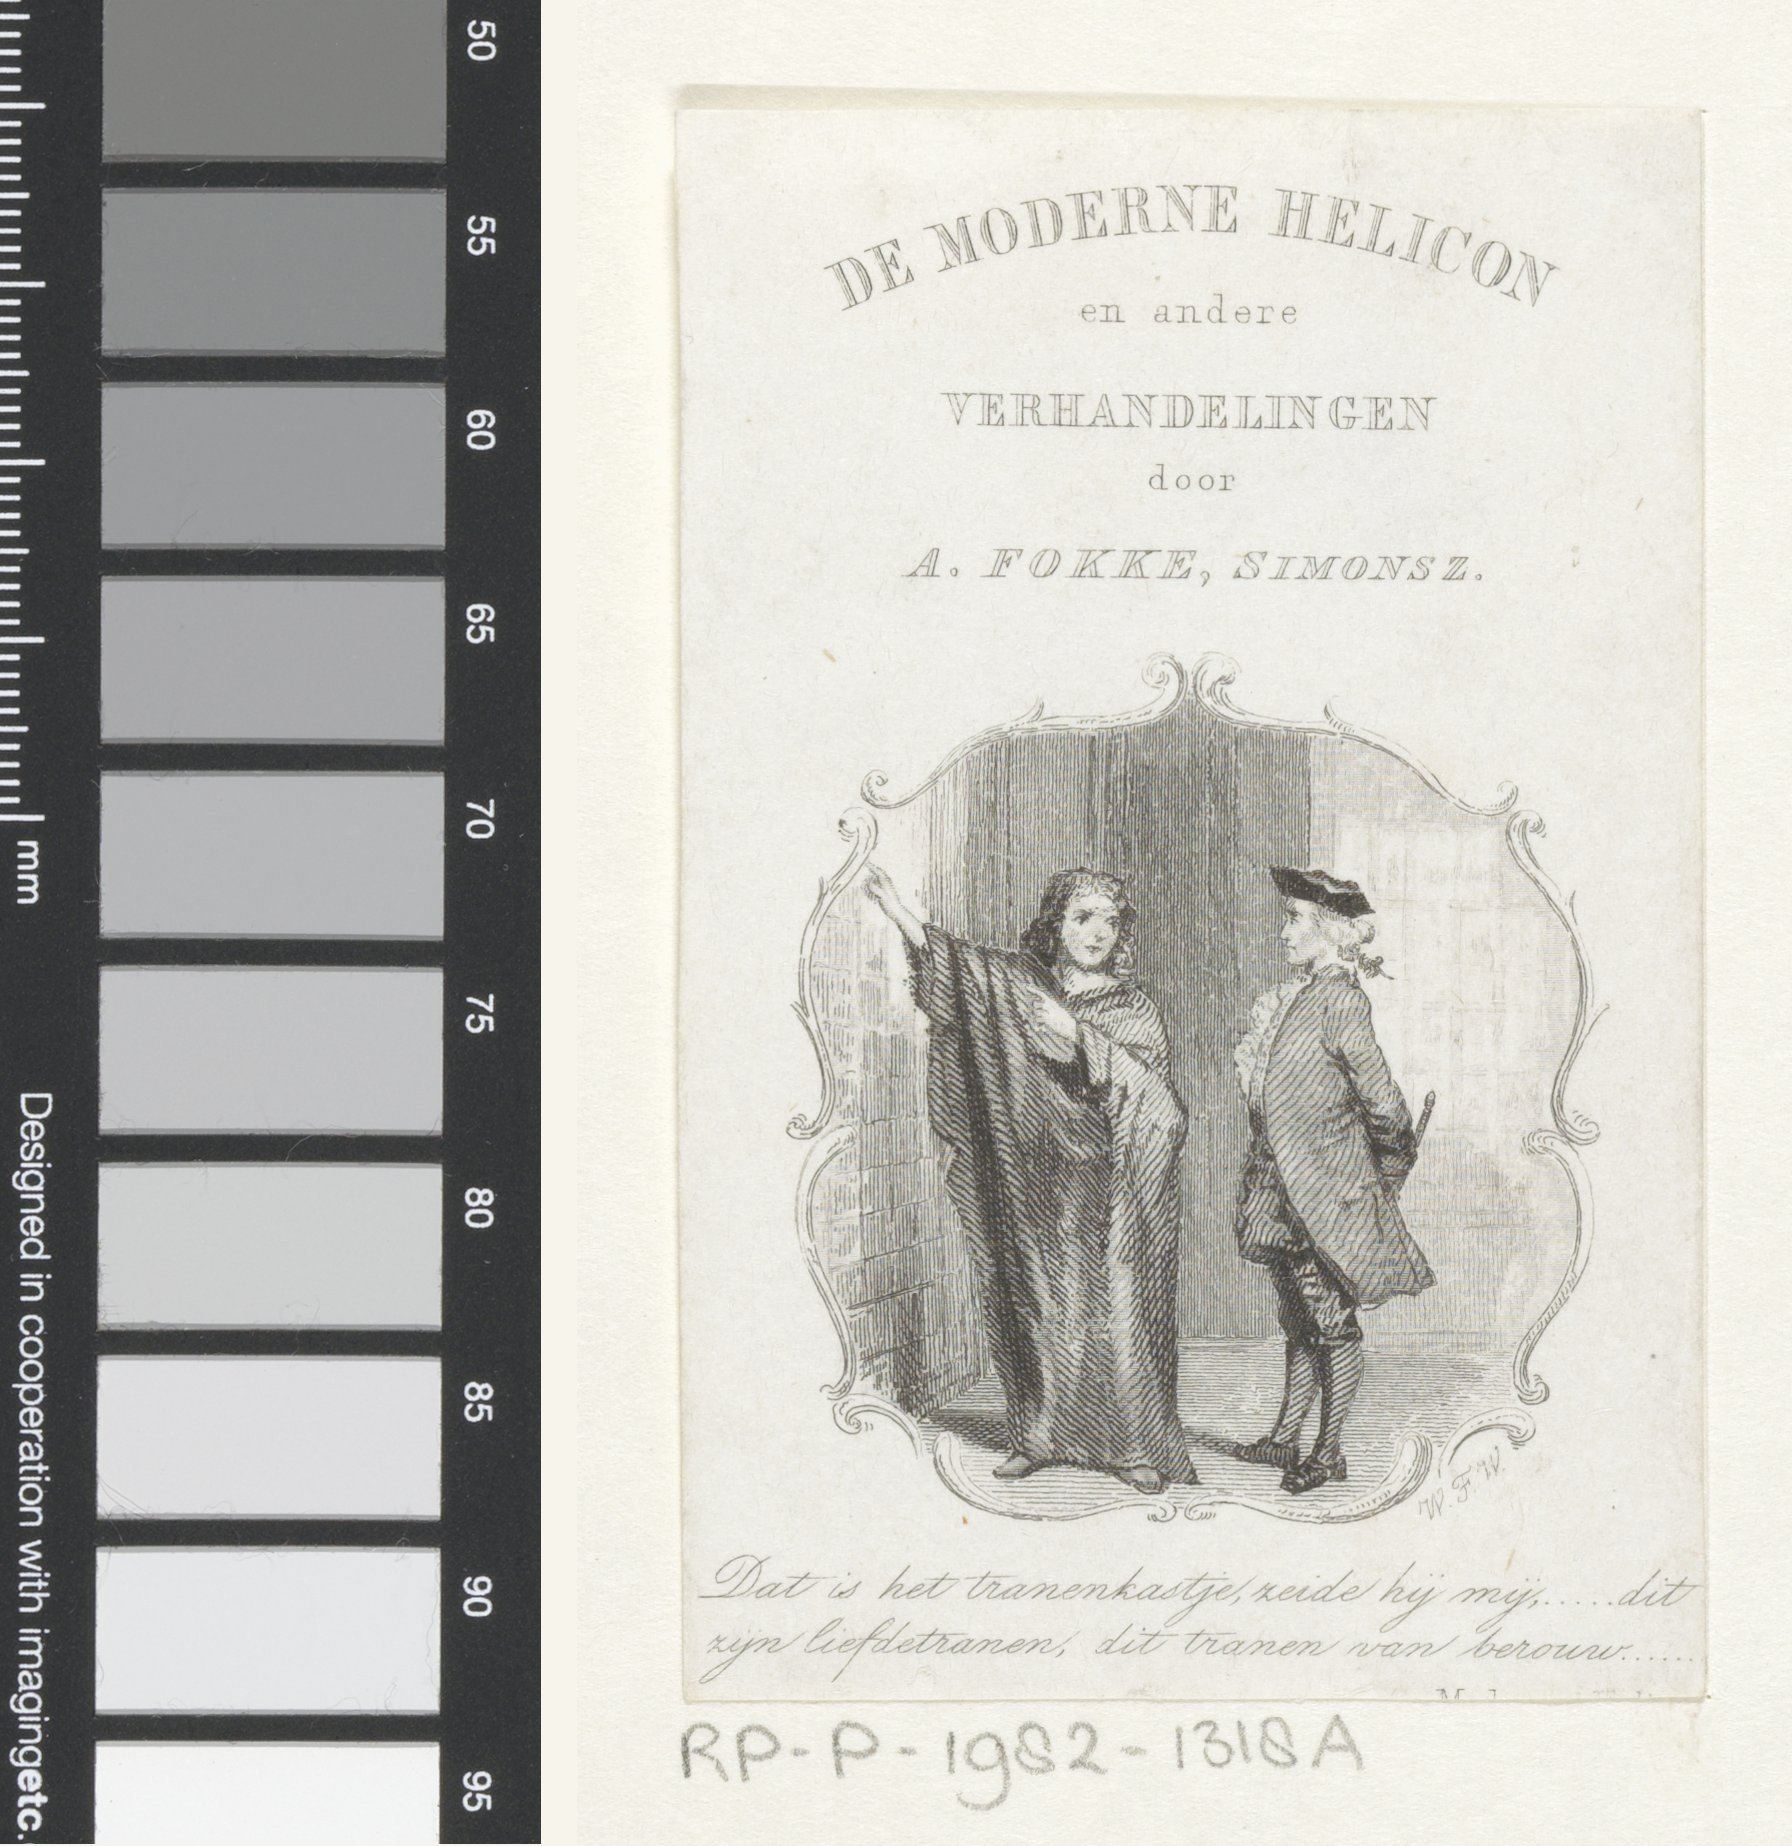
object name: print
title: Apollo toont dichter een kast vol tranen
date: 1852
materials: paper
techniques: engraving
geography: haarlem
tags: (story of) apollo (phoebus), writer, poet, author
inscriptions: collector's mark: Lugt 2228, collector's mark: Lugt 2760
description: De god Apollo heeft een winkel in poëzie geopend waar dichters taalgebruik en metaforen kunnen kopen. Apollo toont een gevoelige dichter zijn assortiment aan tranen.